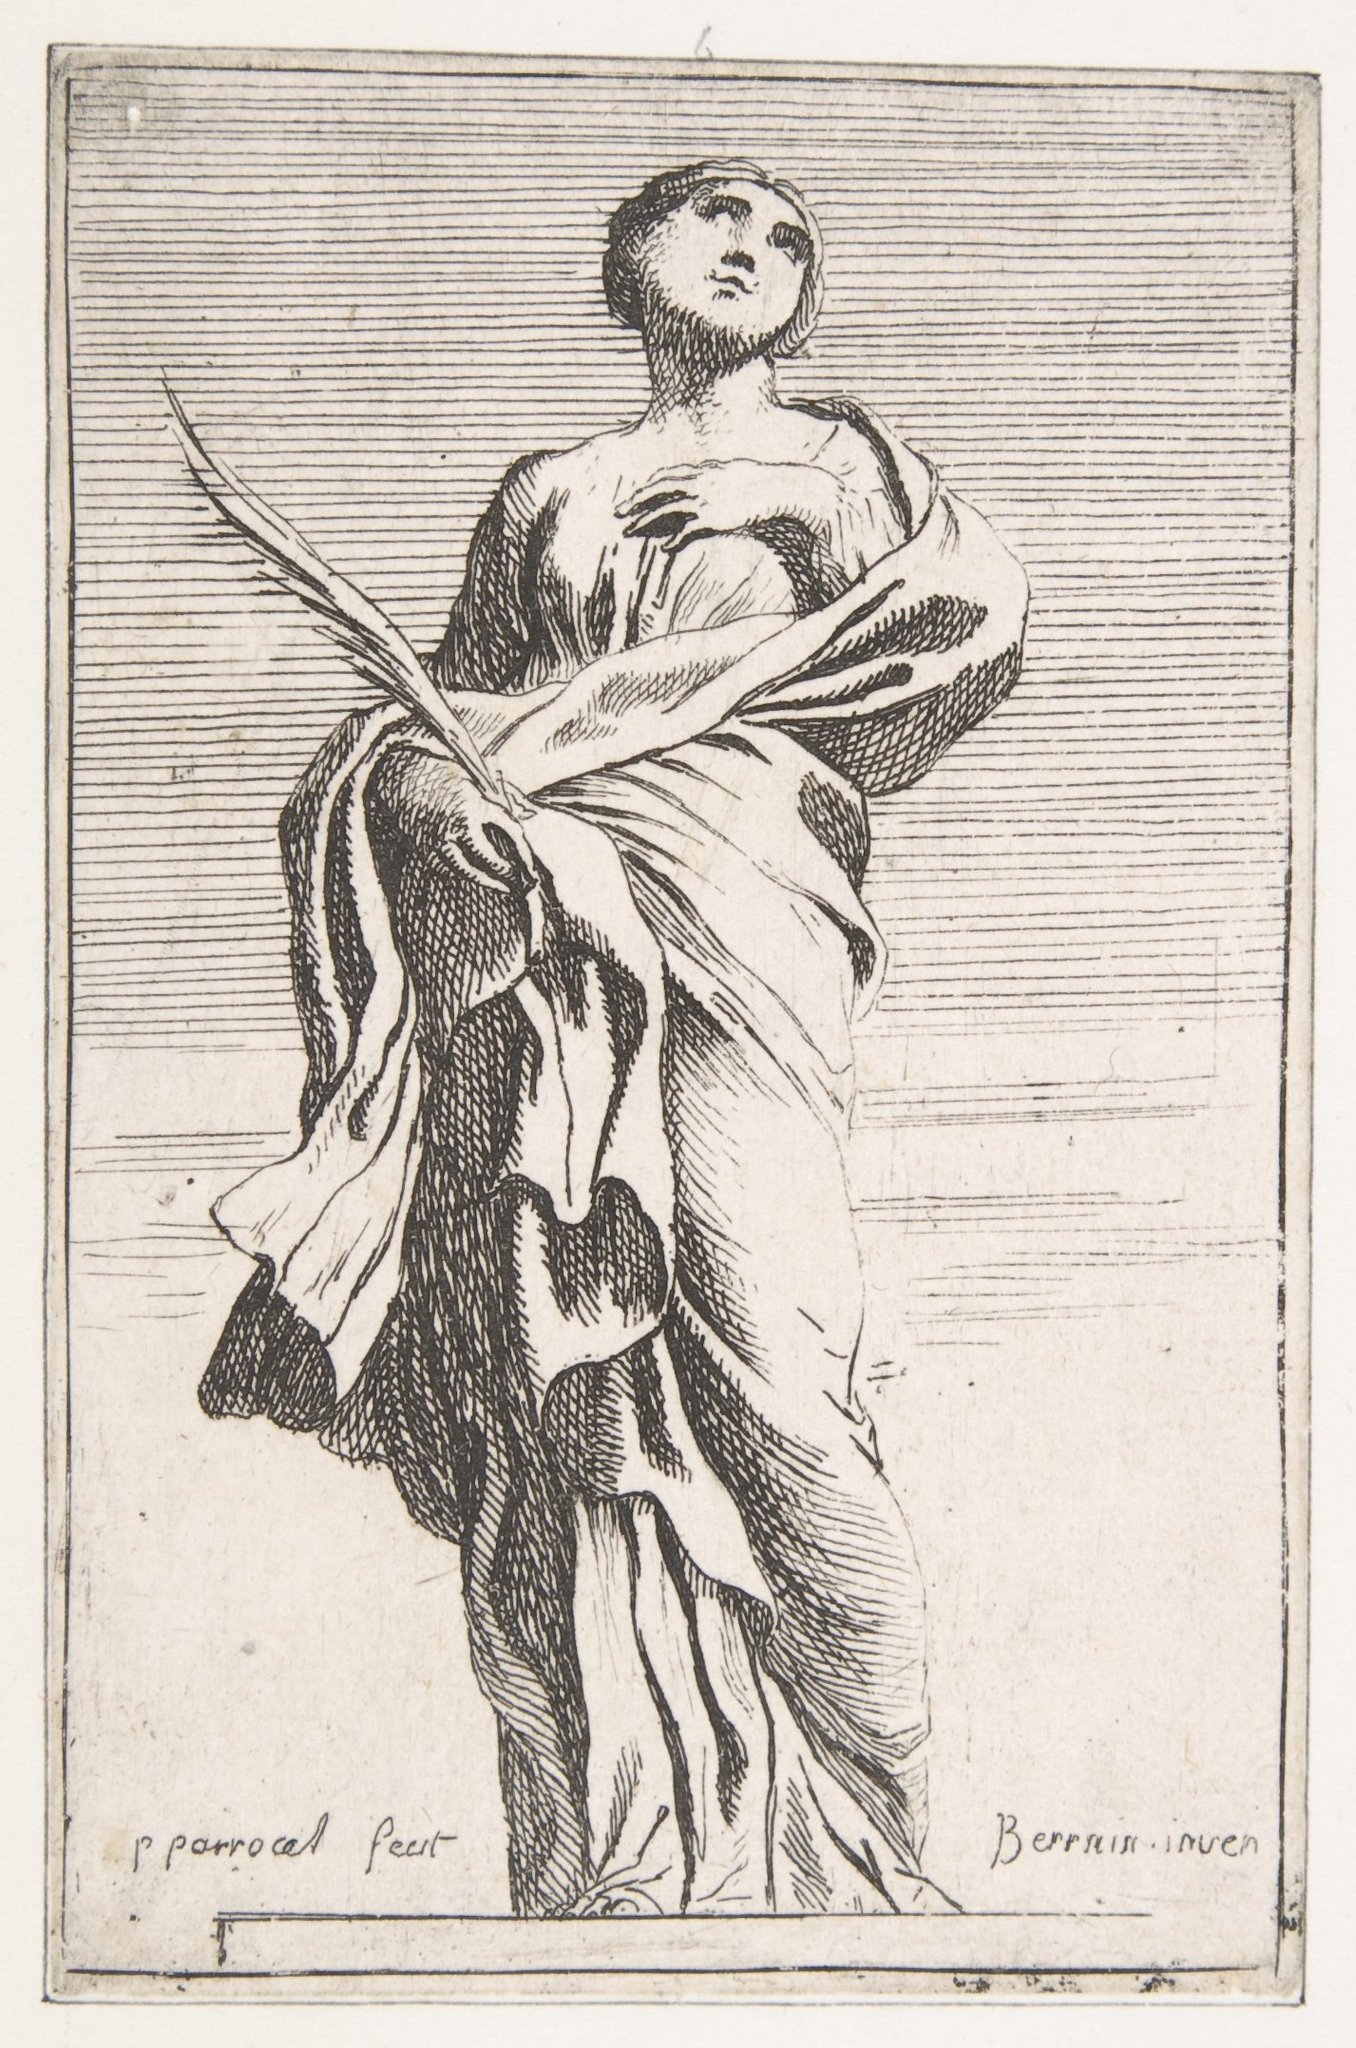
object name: print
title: Standing Female Figure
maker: pierre ignace parrocel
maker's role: artist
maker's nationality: french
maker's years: 1702-1775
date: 1739-1740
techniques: etching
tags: women